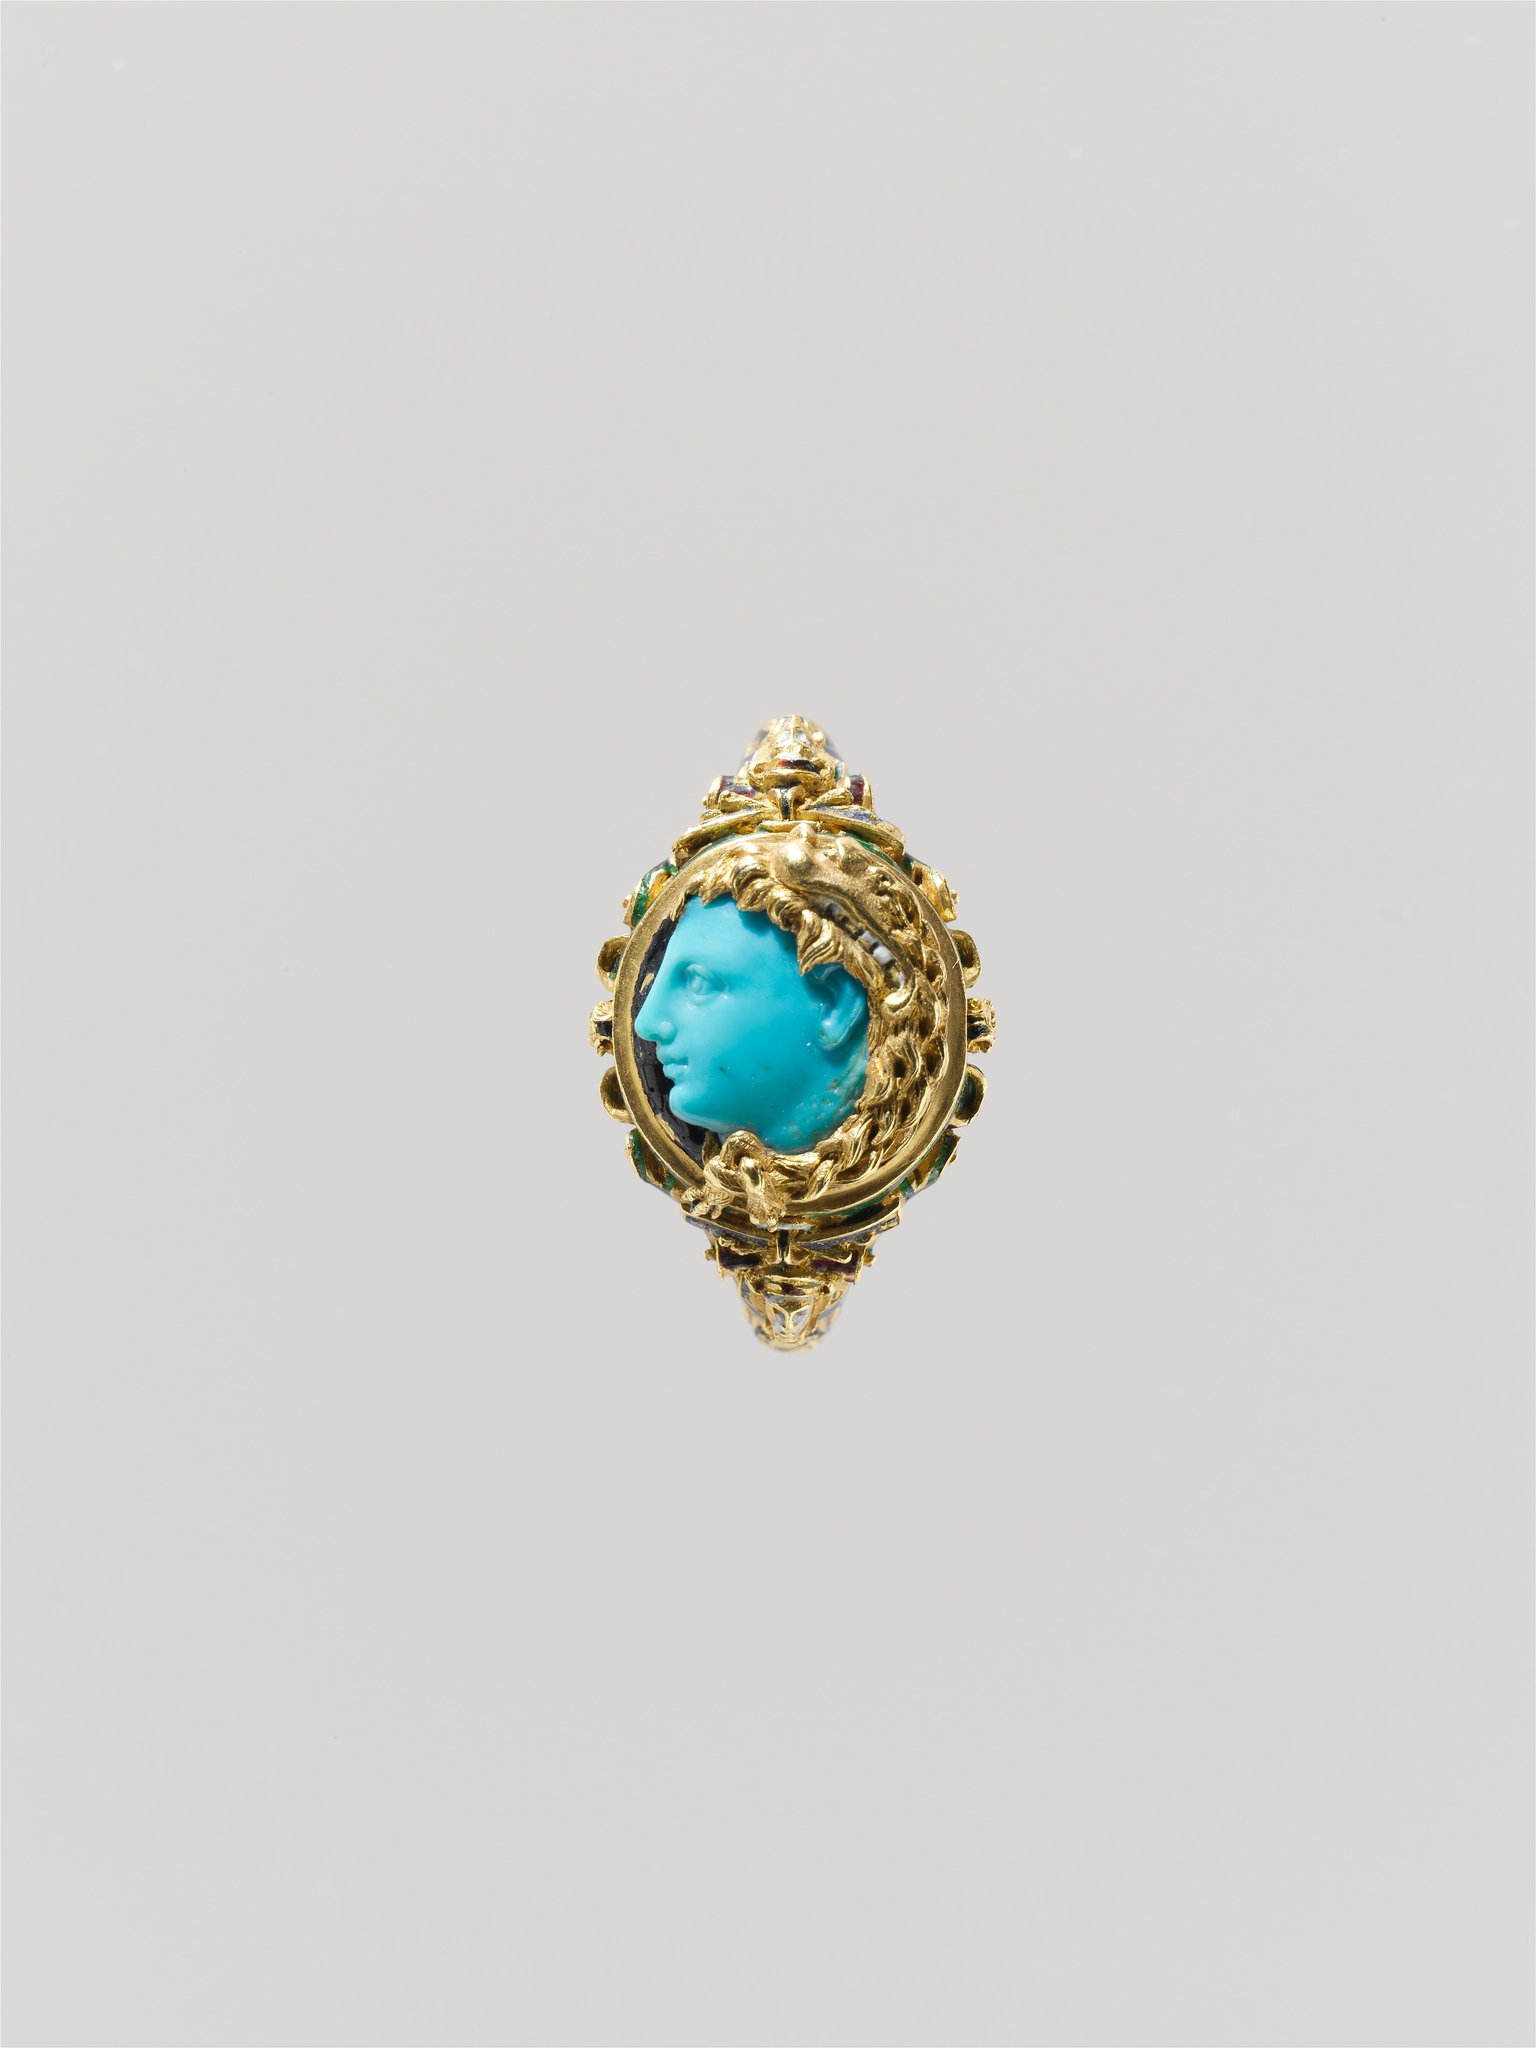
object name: cameo ring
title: Alexander the Great (?)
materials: enamel, gold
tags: alexander the great,profiles